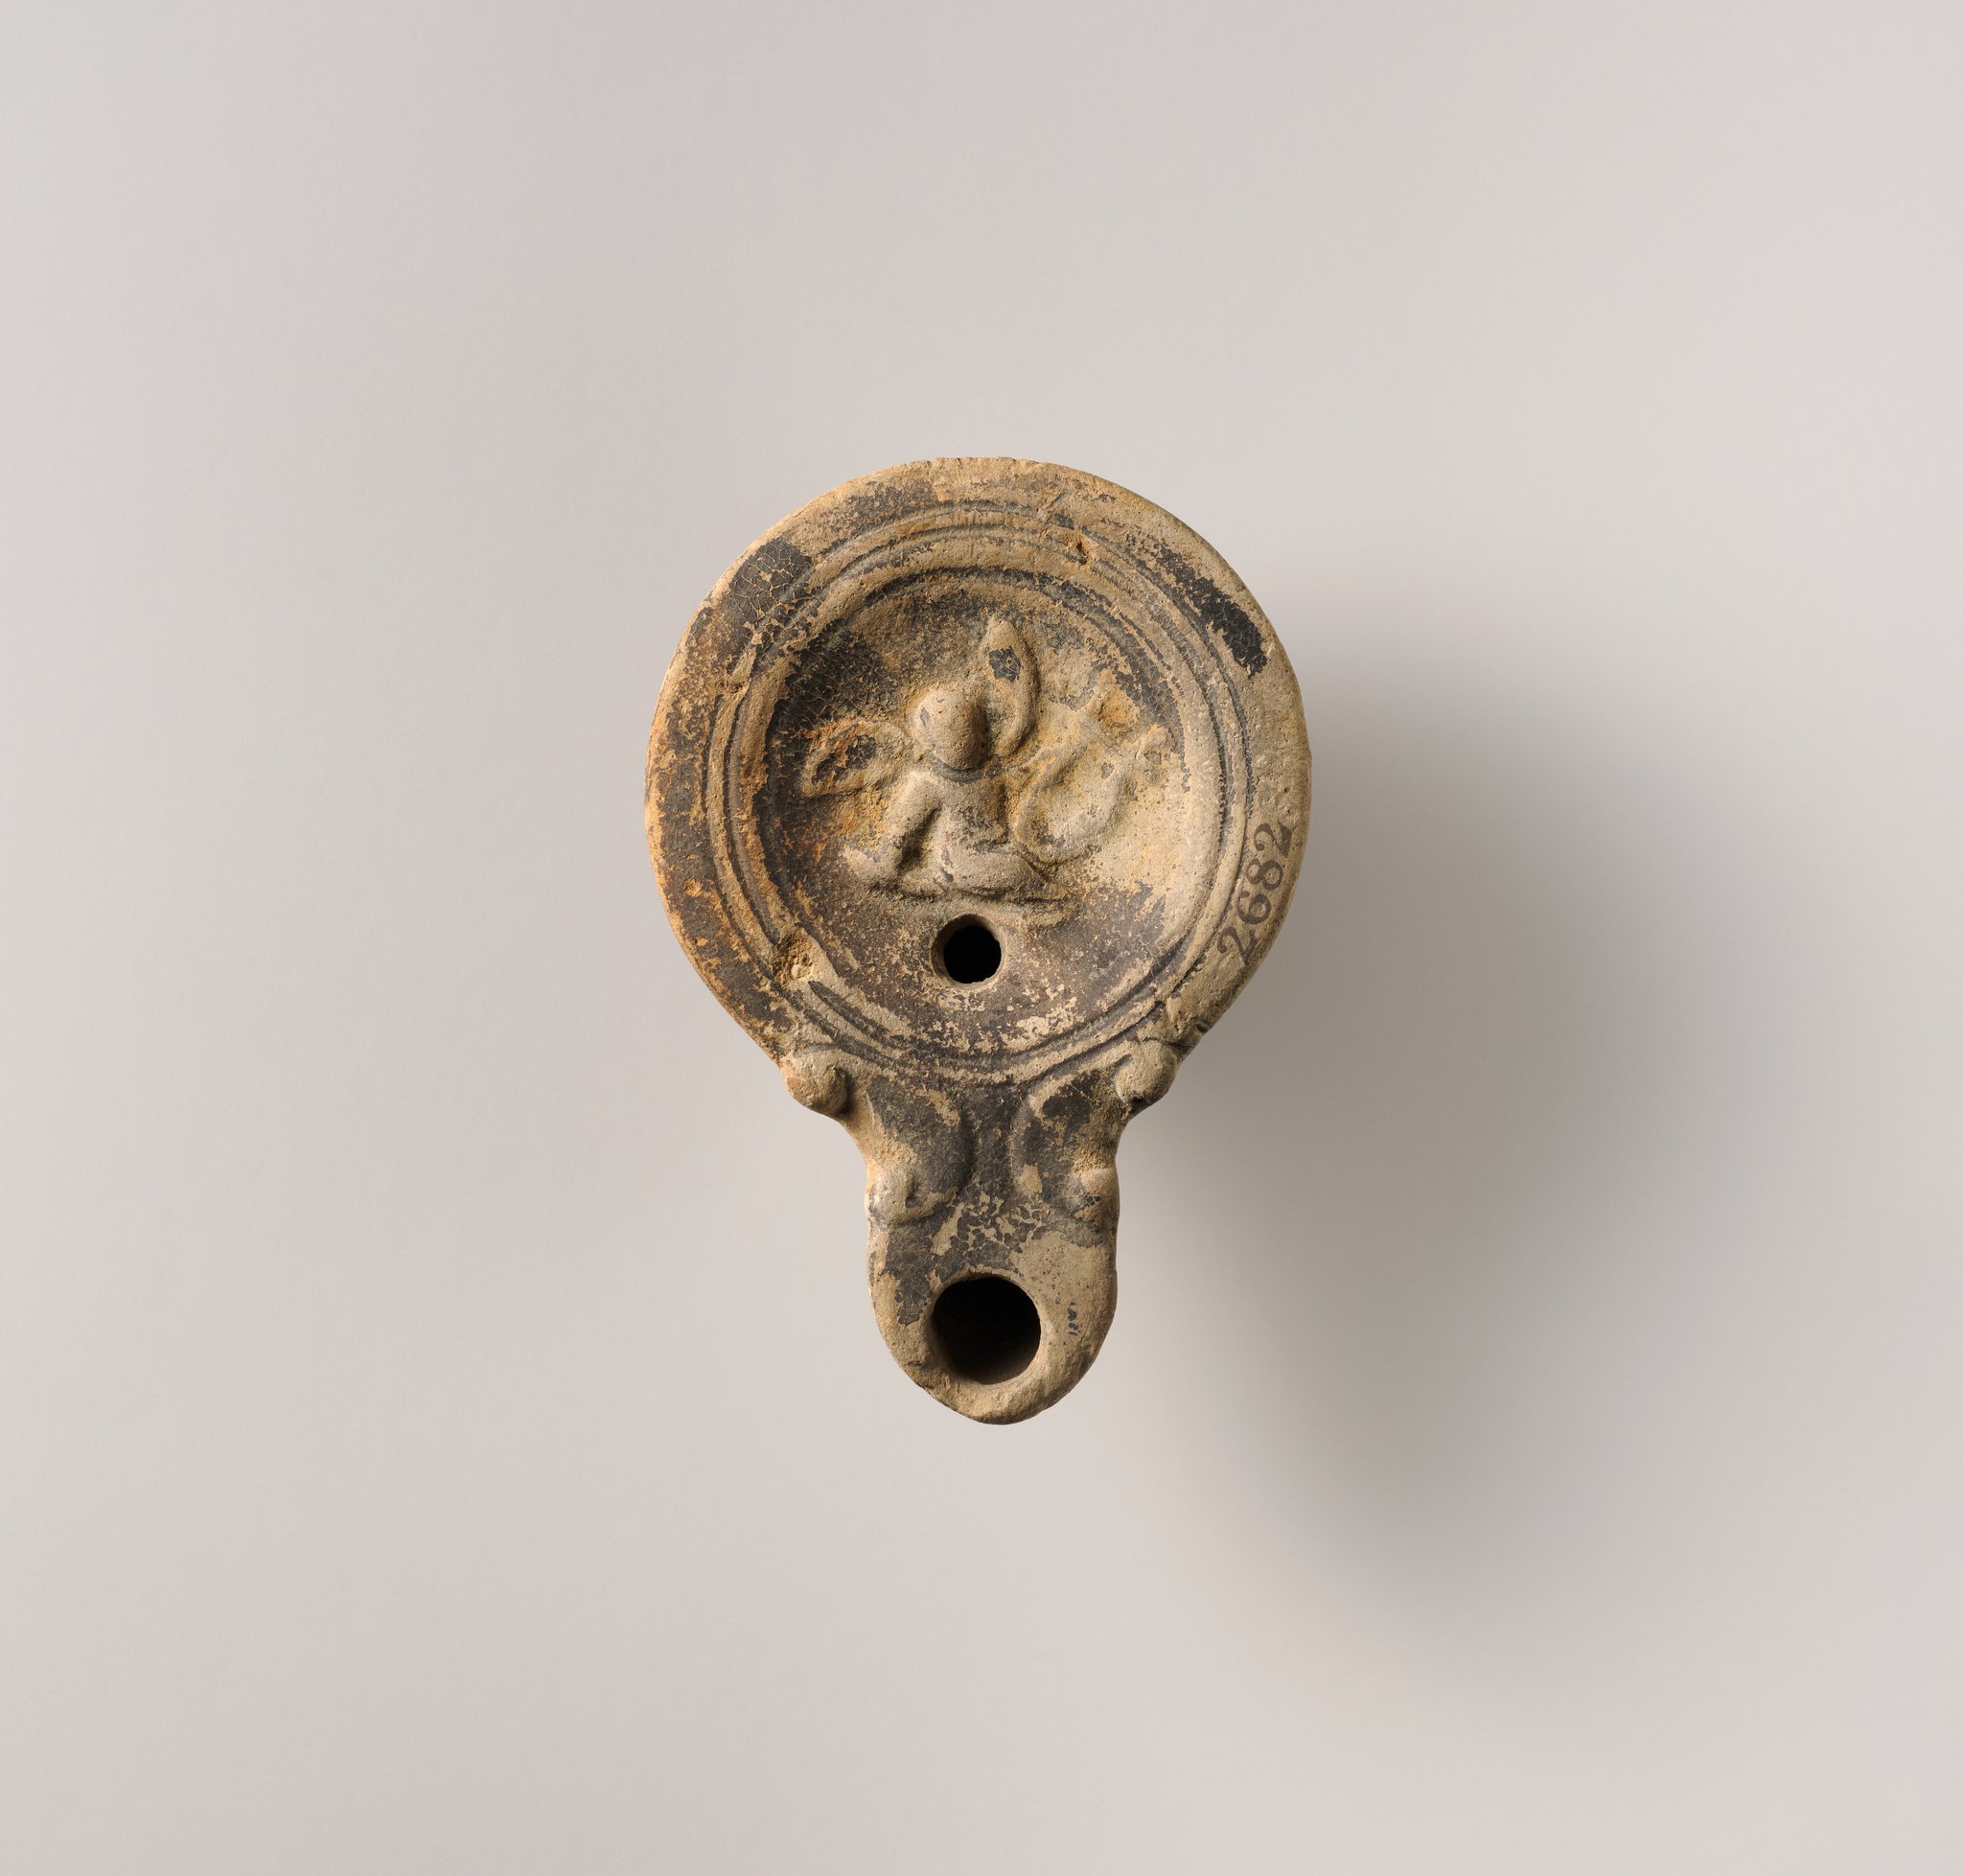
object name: lamp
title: Terracotta oil lamp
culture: roman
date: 100 BCE-100 CE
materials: terracotta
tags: eros